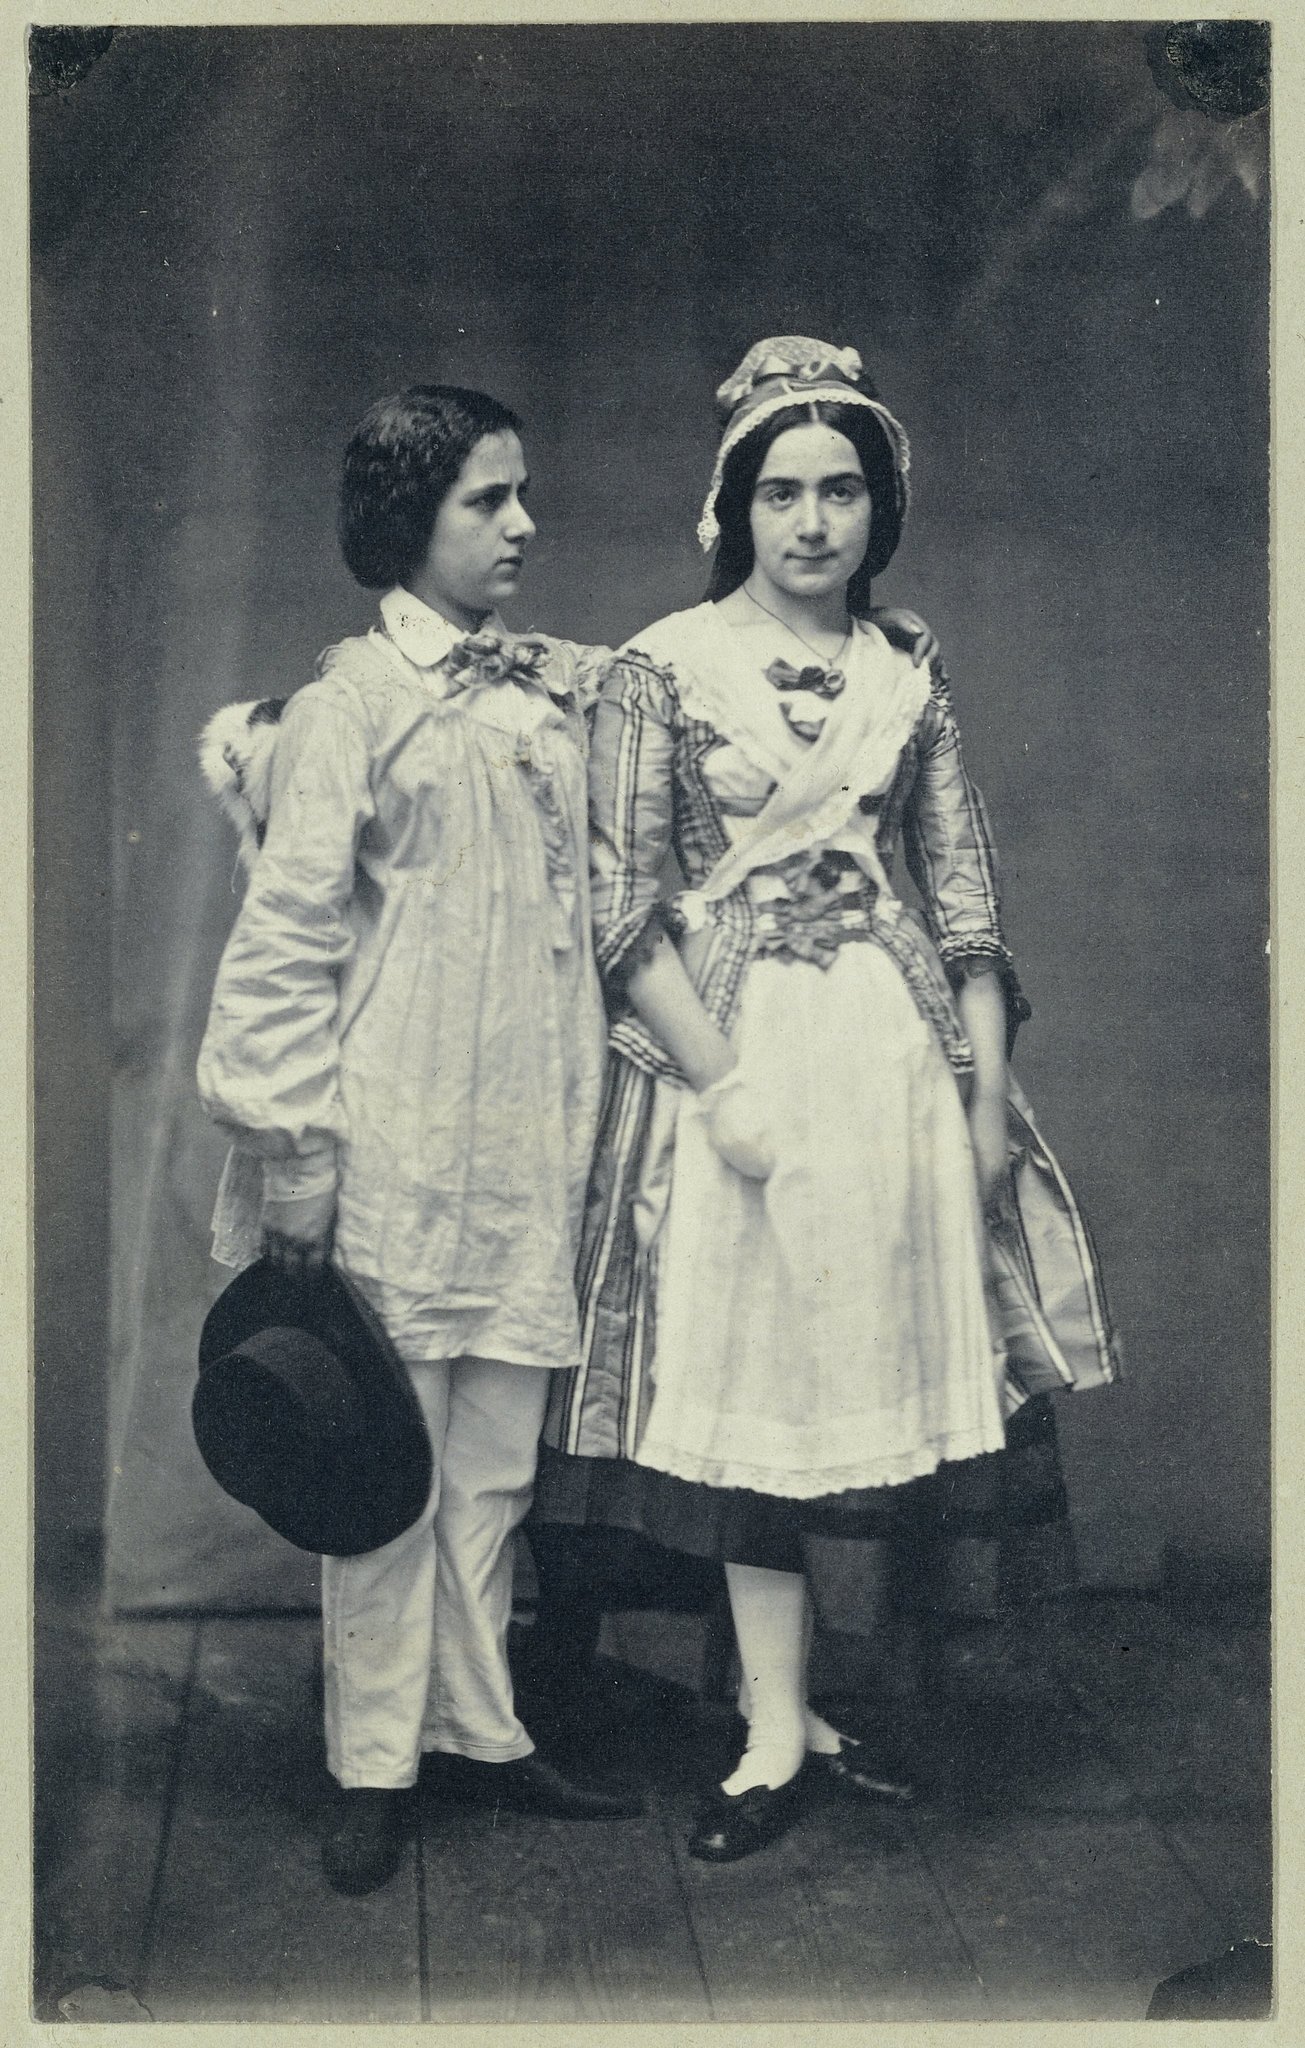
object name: photograph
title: Portret van Anna Gratia Asser en een onbekend meisje in toneelkostuum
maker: eduard isaac asser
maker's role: amateurfotograaf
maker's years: 1809-1894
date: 1856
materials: cardboard, paper, photographic support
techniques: salted paper print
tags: historical persons - bb - woman